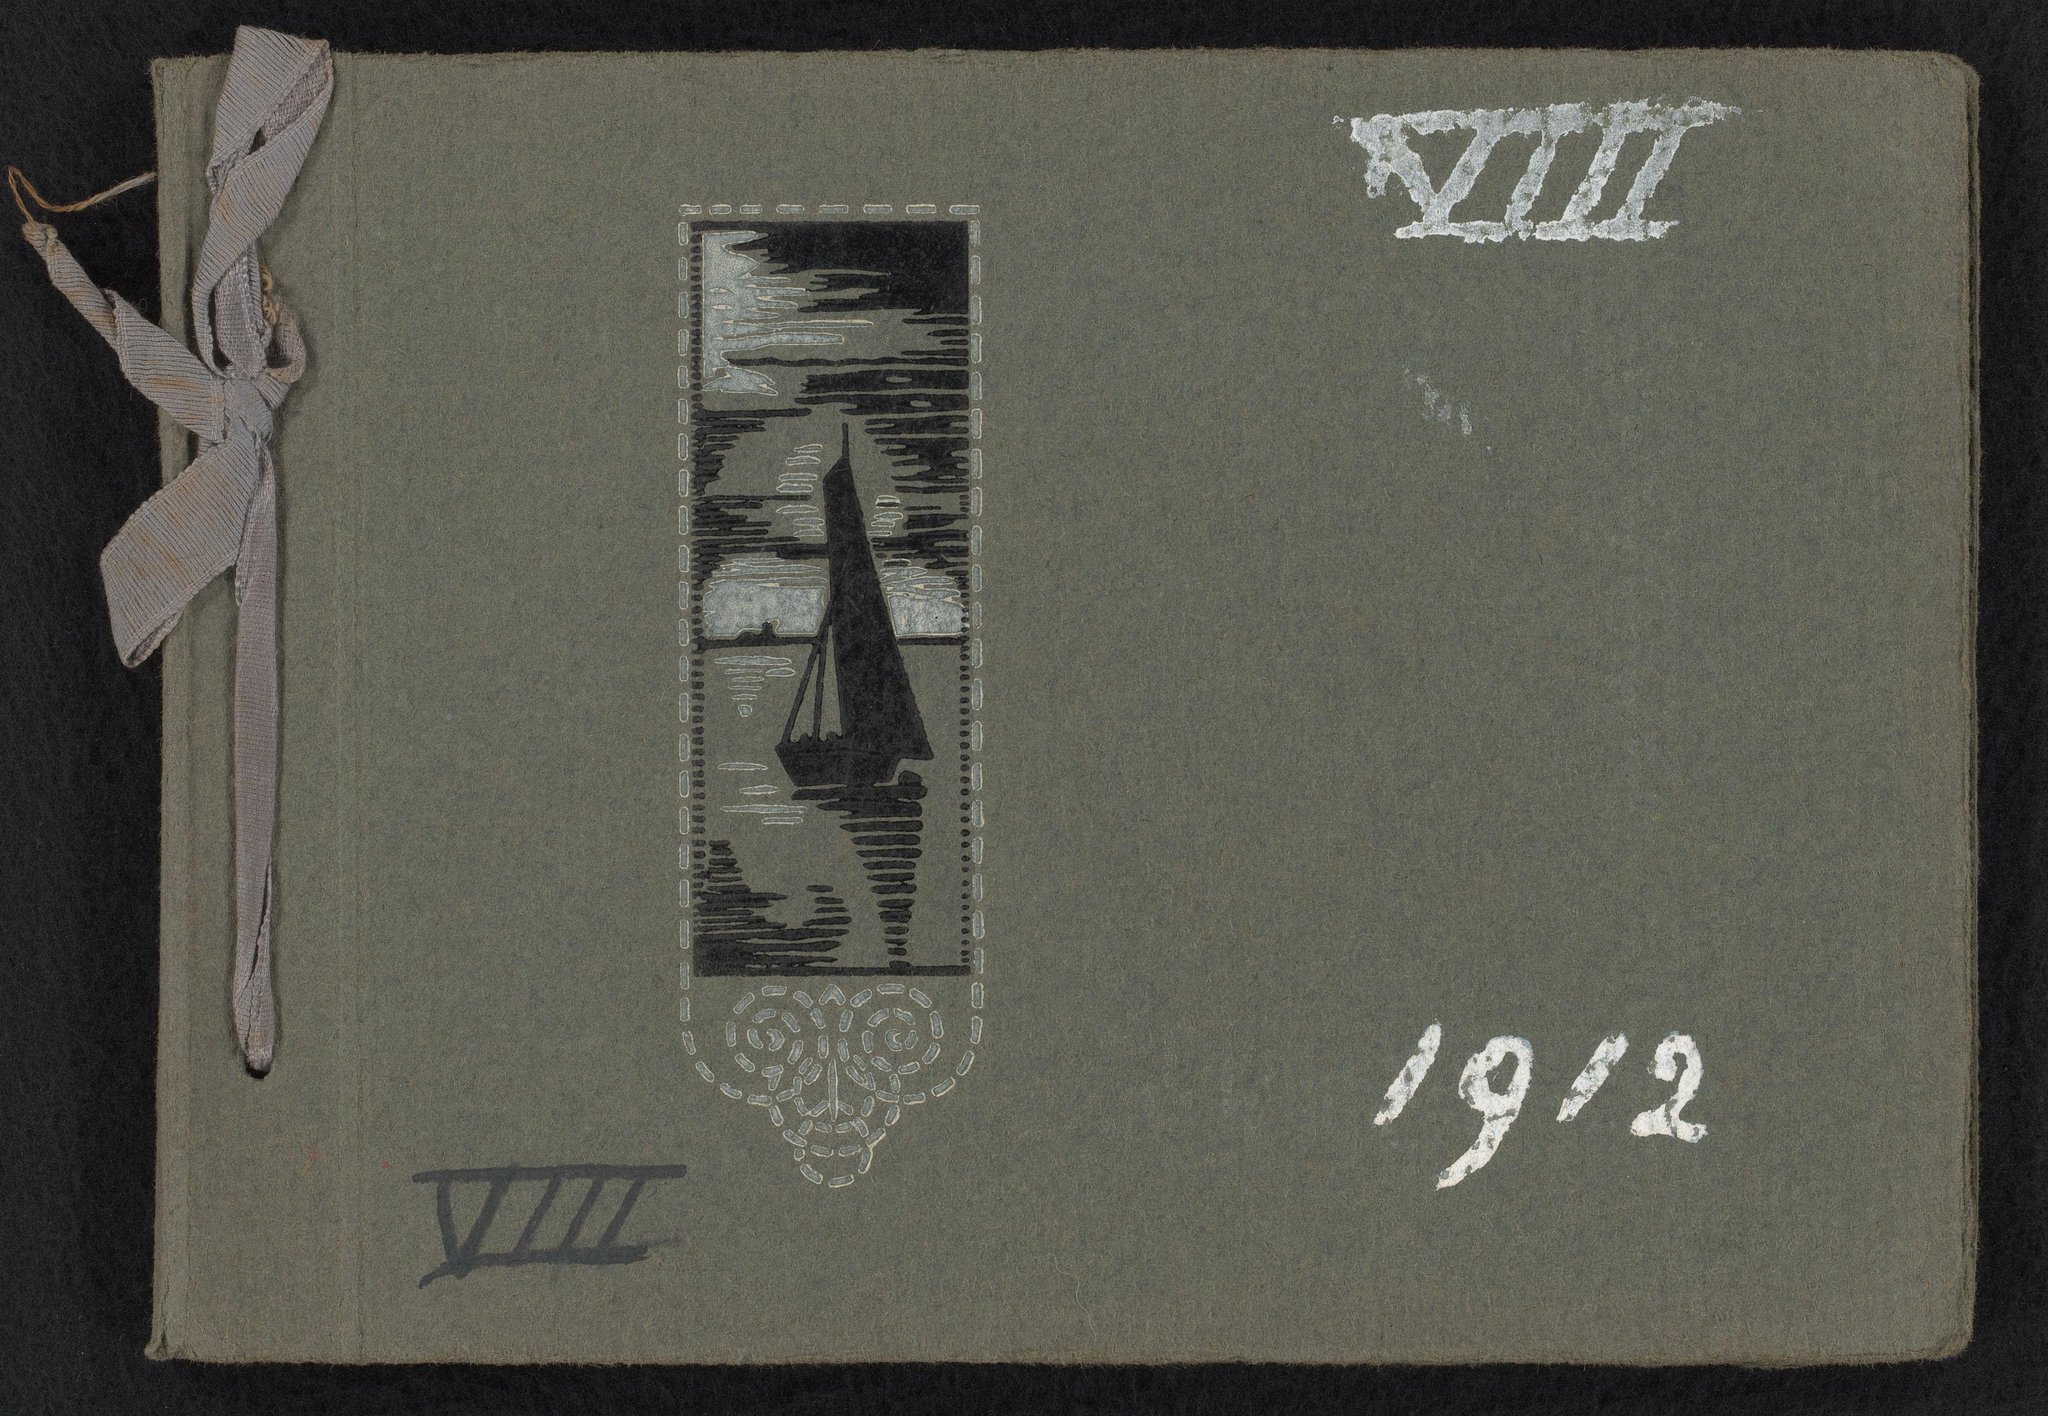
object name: photograph album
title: Fotoalbum van familie Van den Berg, 1912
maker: hendrik herman van den berg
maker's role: amateurfotograaf, jurist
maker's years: 1875-1944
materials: paper, cardboard, ink, paint, ribbon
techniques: gelatin silver print, pen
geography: netherlands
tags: the hague, caroline louise van den berg-van den berg, carel frederik van den berg (cay), frank willem van den berg (1912-1998), historical persons, infant, baby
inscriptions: inscription: ‘VIII/ VIII/ 1912’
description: Insteekalbum met 14 foto's op 14 bladen. Het album bevat foto's van Frank Willem kort na zijn geboorte. Op enkele foto's staat Caroline van den Berg met de pasgeboren Frank. Op de laatste vier foto's staat Cay van den Berg. De fotograaf en samensteller van het album is waarschijnlijk Hendrik Herman van den Berg.